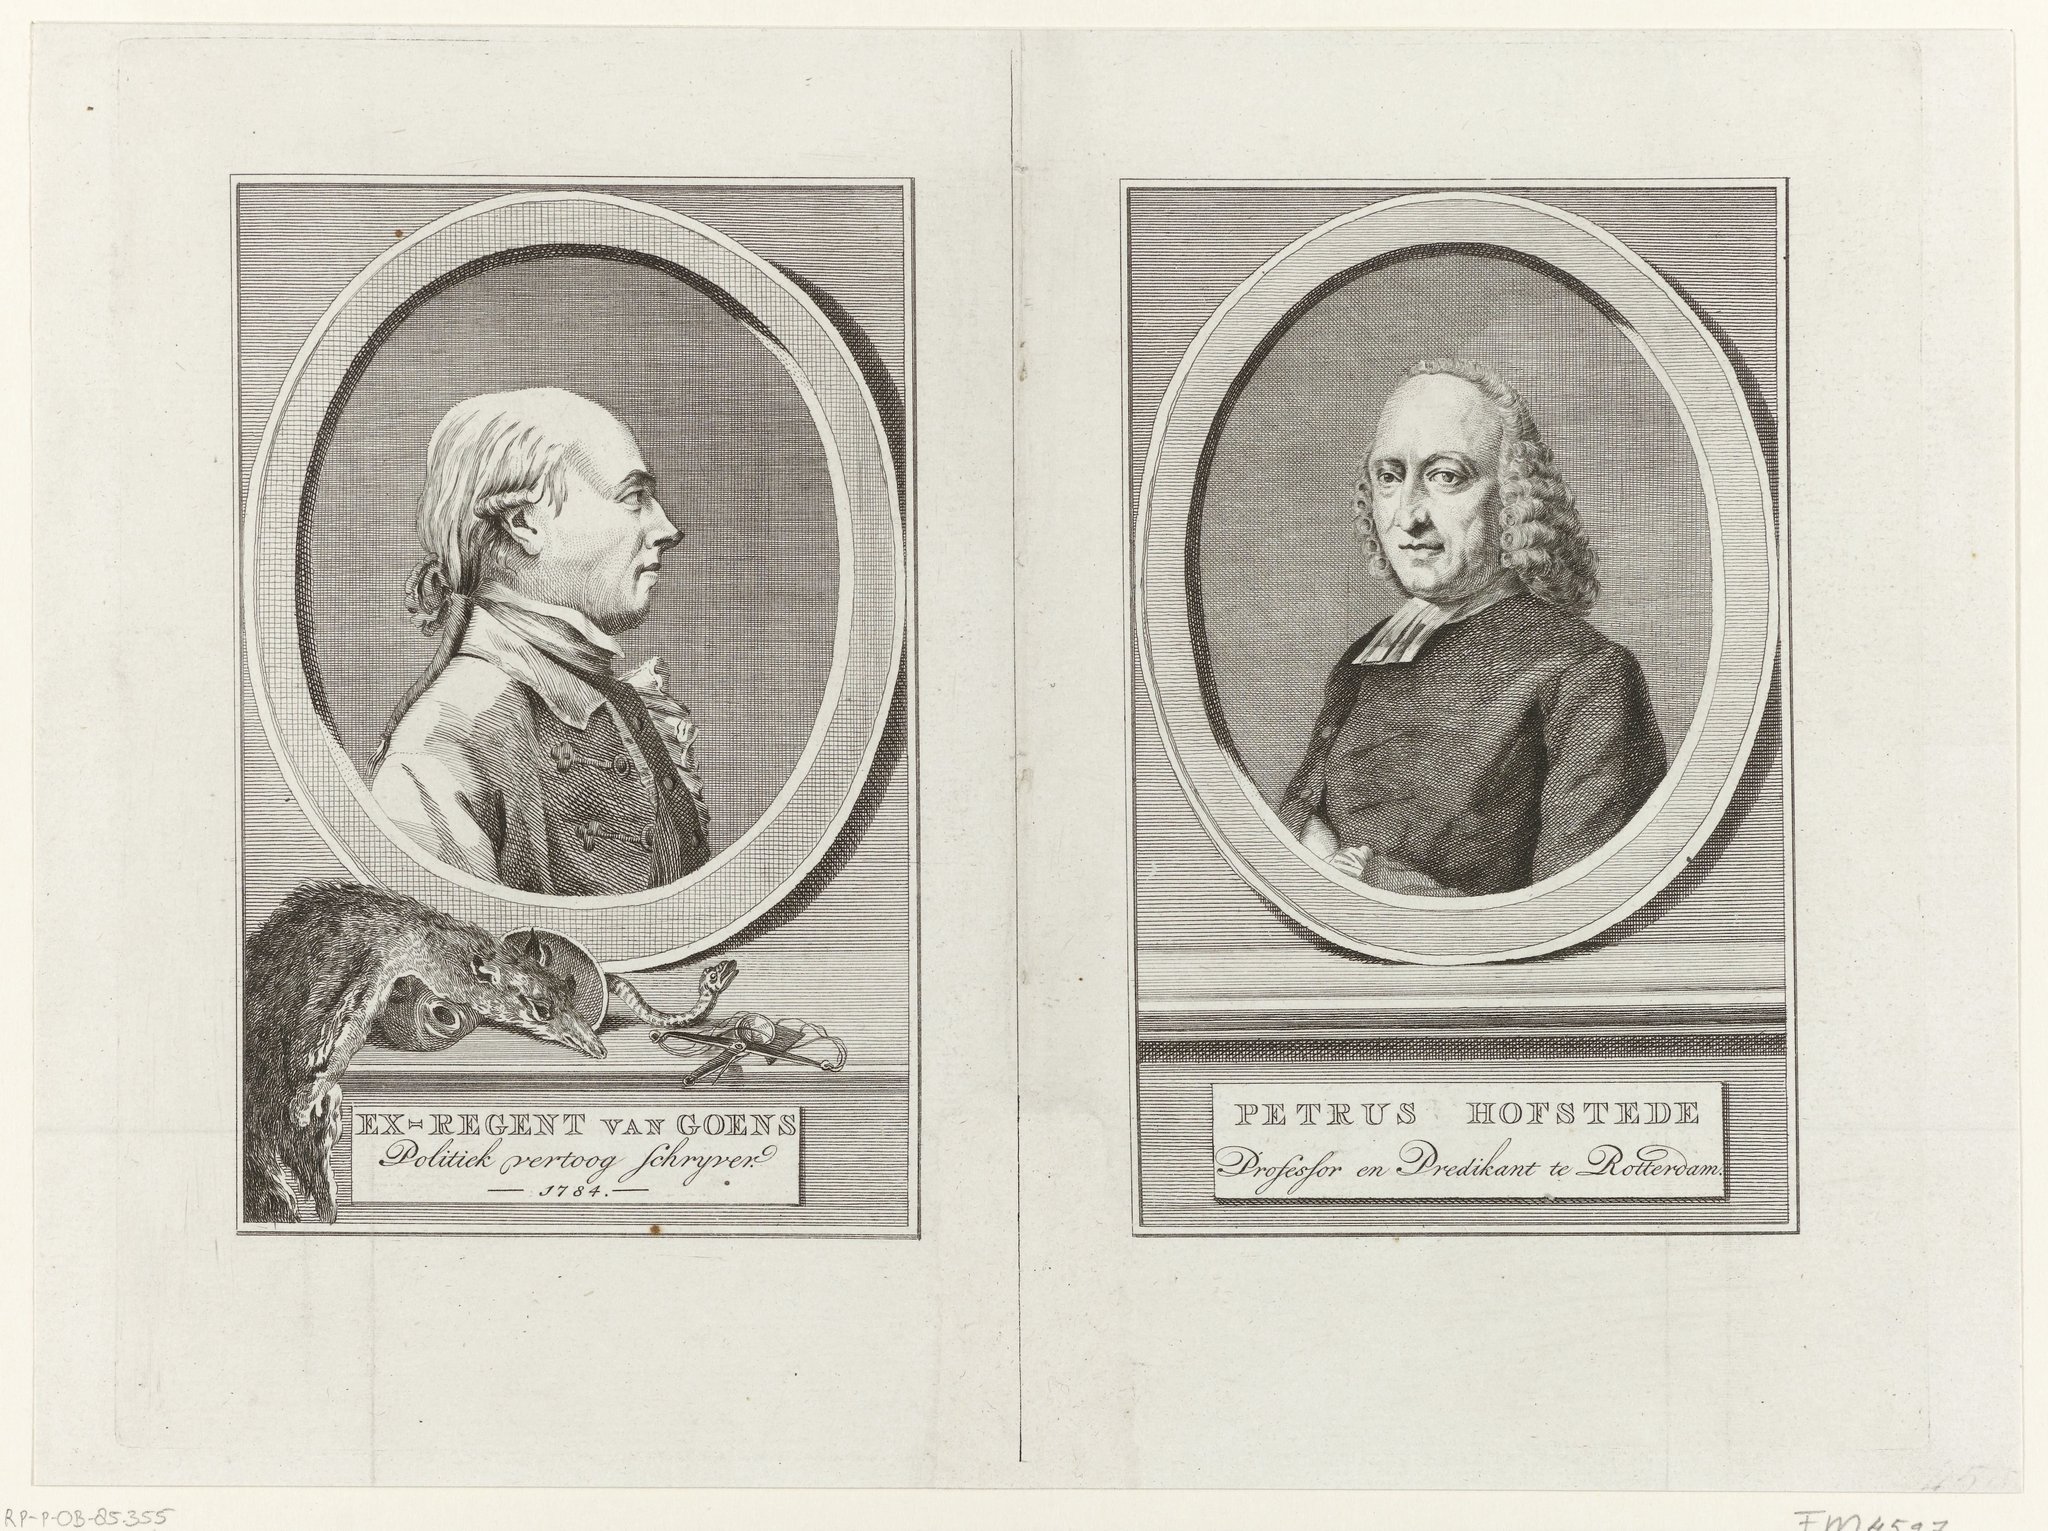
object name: print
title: Ex-regent van Goens/ Politiek vertoog schryver. 1784 / Petrus Hofstede/ Professor en Predikant te Rotterdam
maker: Anonymous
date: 1782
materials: paper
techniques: engraving, etching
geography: northern netherlands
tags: rotterdam, petrus hofstede, utrecht, patriots (1780-1795)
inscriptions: collector's mark: Lugt 2228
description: Bij deze portretten een begeleidend blad met verzen getiteld: Een viertal verzen, op den alom befaamden ex-regent R.M. van Goens. Schelm voor't vaderland, en beminnaar van het Oranje huis / Een vyftal verzen, op den berugten Petrus Hofstede, schelm voor't vaderland, en beminnaar van het Oranje huis. S.l.s.n. [1782]. De portretten zijn door Muller beschreven bij het jaar 1784.